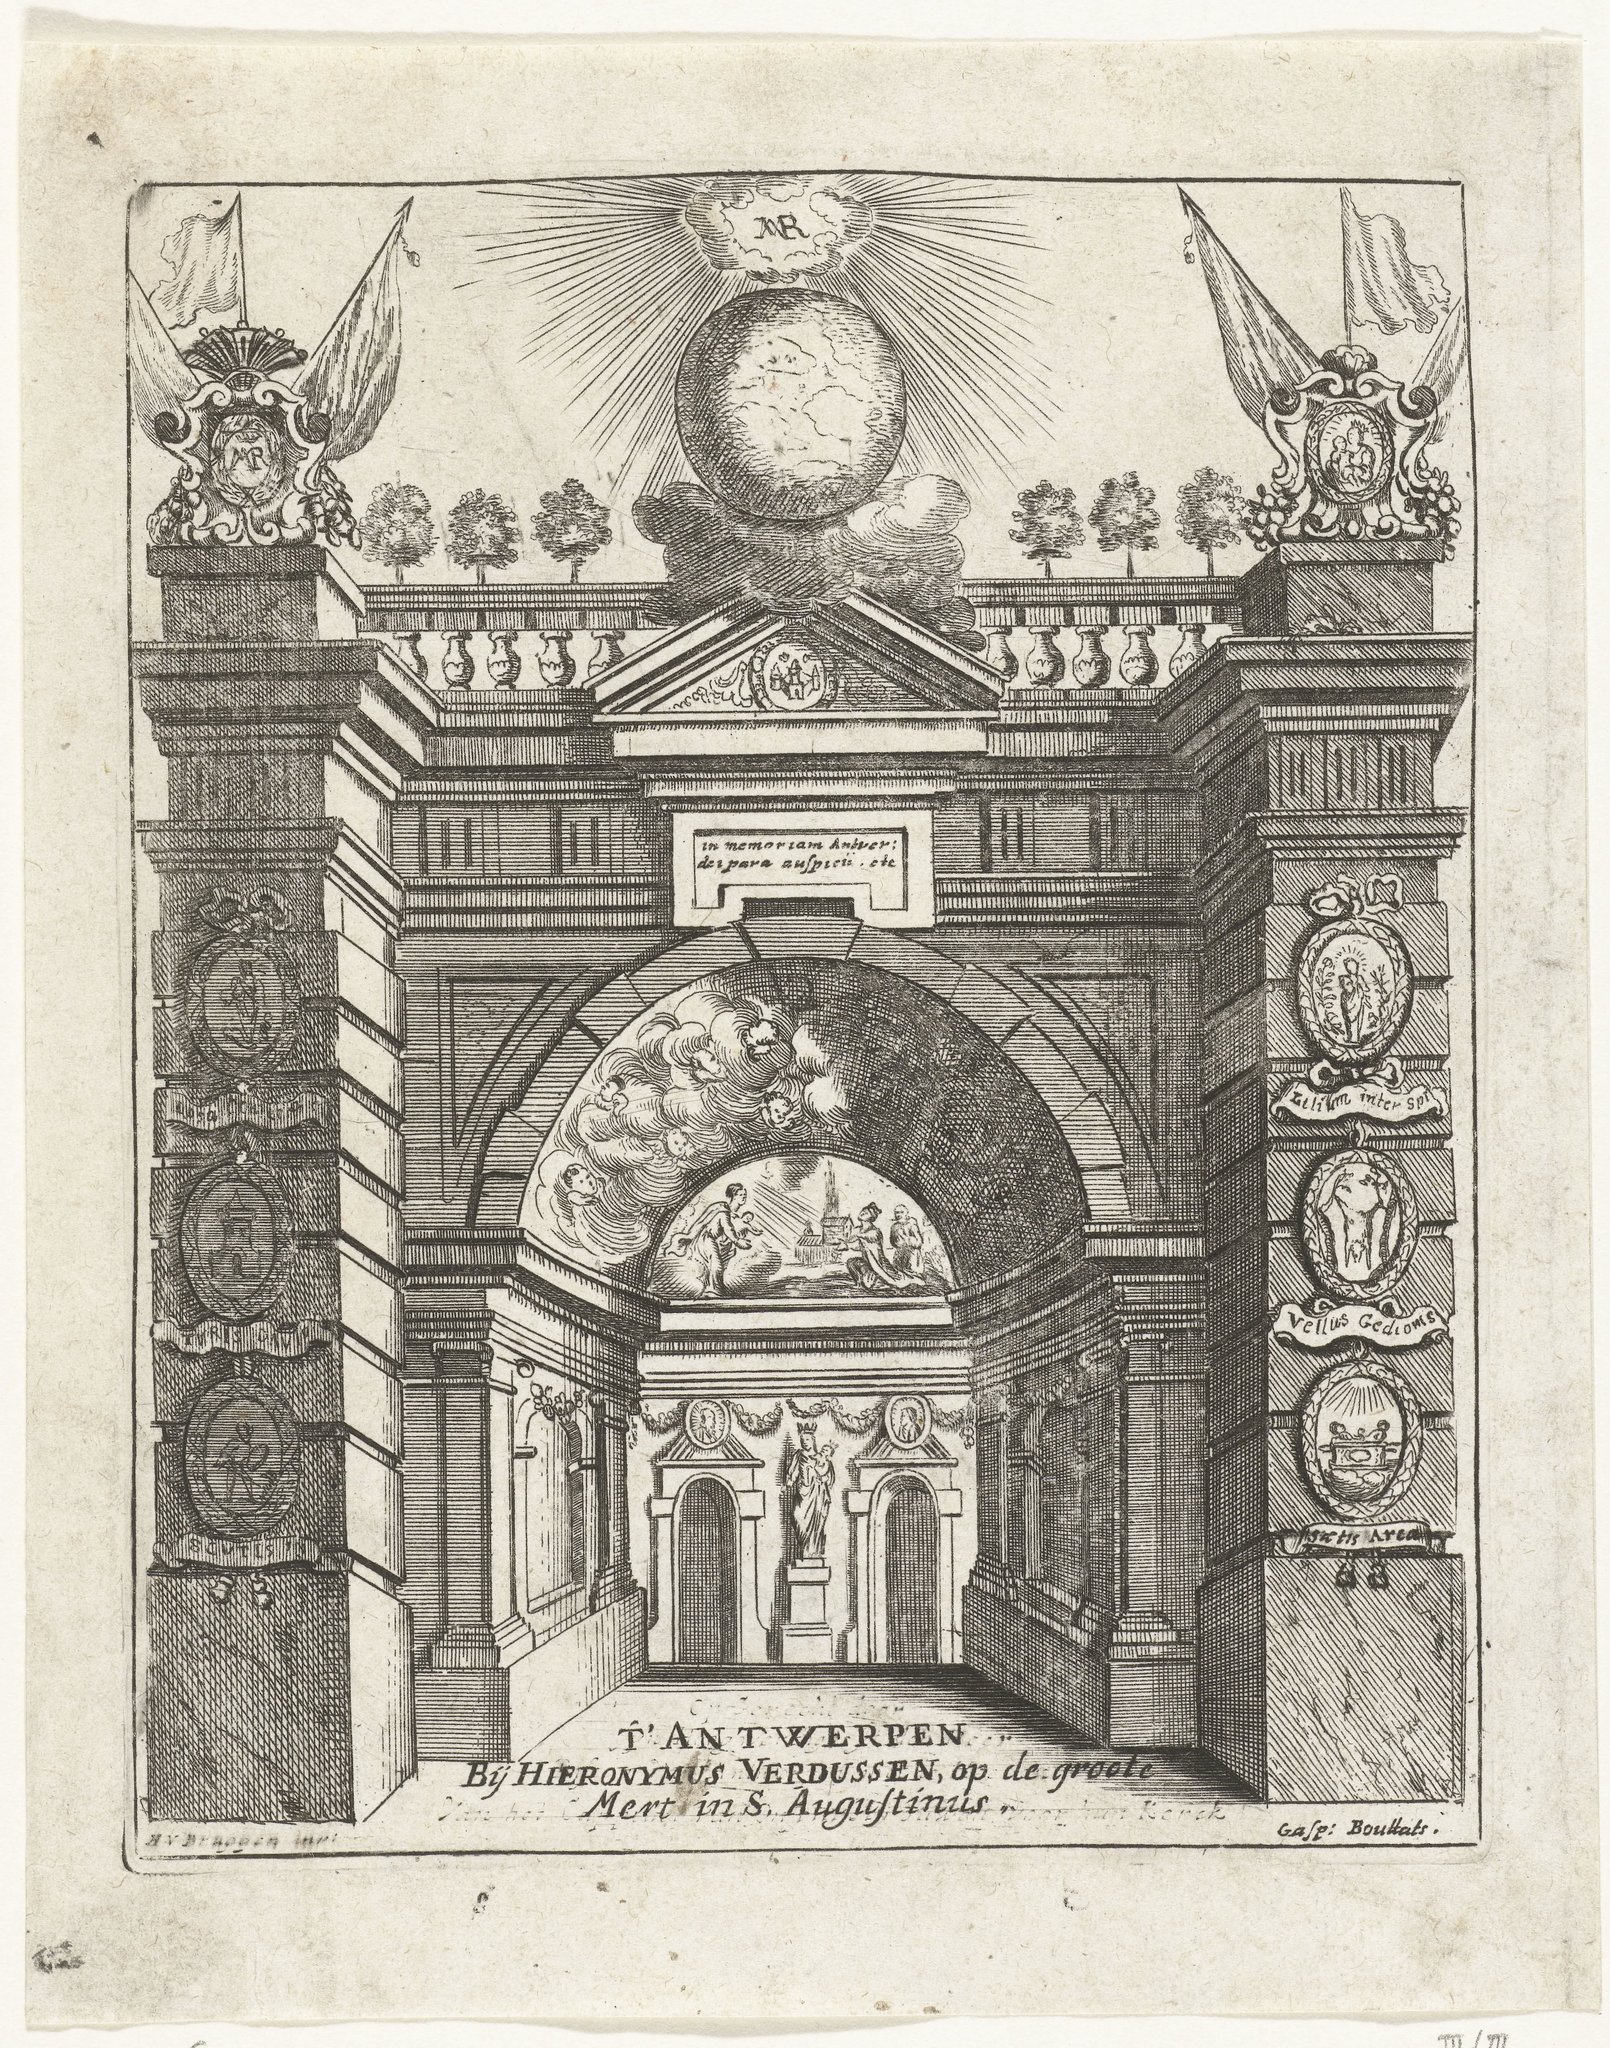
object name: print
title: Triomfpoort opgericht door de bisschop van Antwerpen voor de Onze-Lieve-Vrouwekathedraal, 1685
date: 1685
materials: paper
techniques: etching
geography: southern netherlands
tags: triumphal arch, antwerp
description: Gebruikt als illustratie in: Hondert-jaerigh jubile-vreught bewesen in dese stadt Antwerpen ter oorsaecke vande herstellinge des geloofs in't jaer 1585. door de glorieuse waepenen van sijne catholijcke majesteyt, onder t'beleyt van ... Alexander Farnesius ... / Ghemaeckt ende by-een vergadert door ... Petrus Franciscus de Smidt, Hieronymus Verdussen den jonghere, Antwerpen 1685.